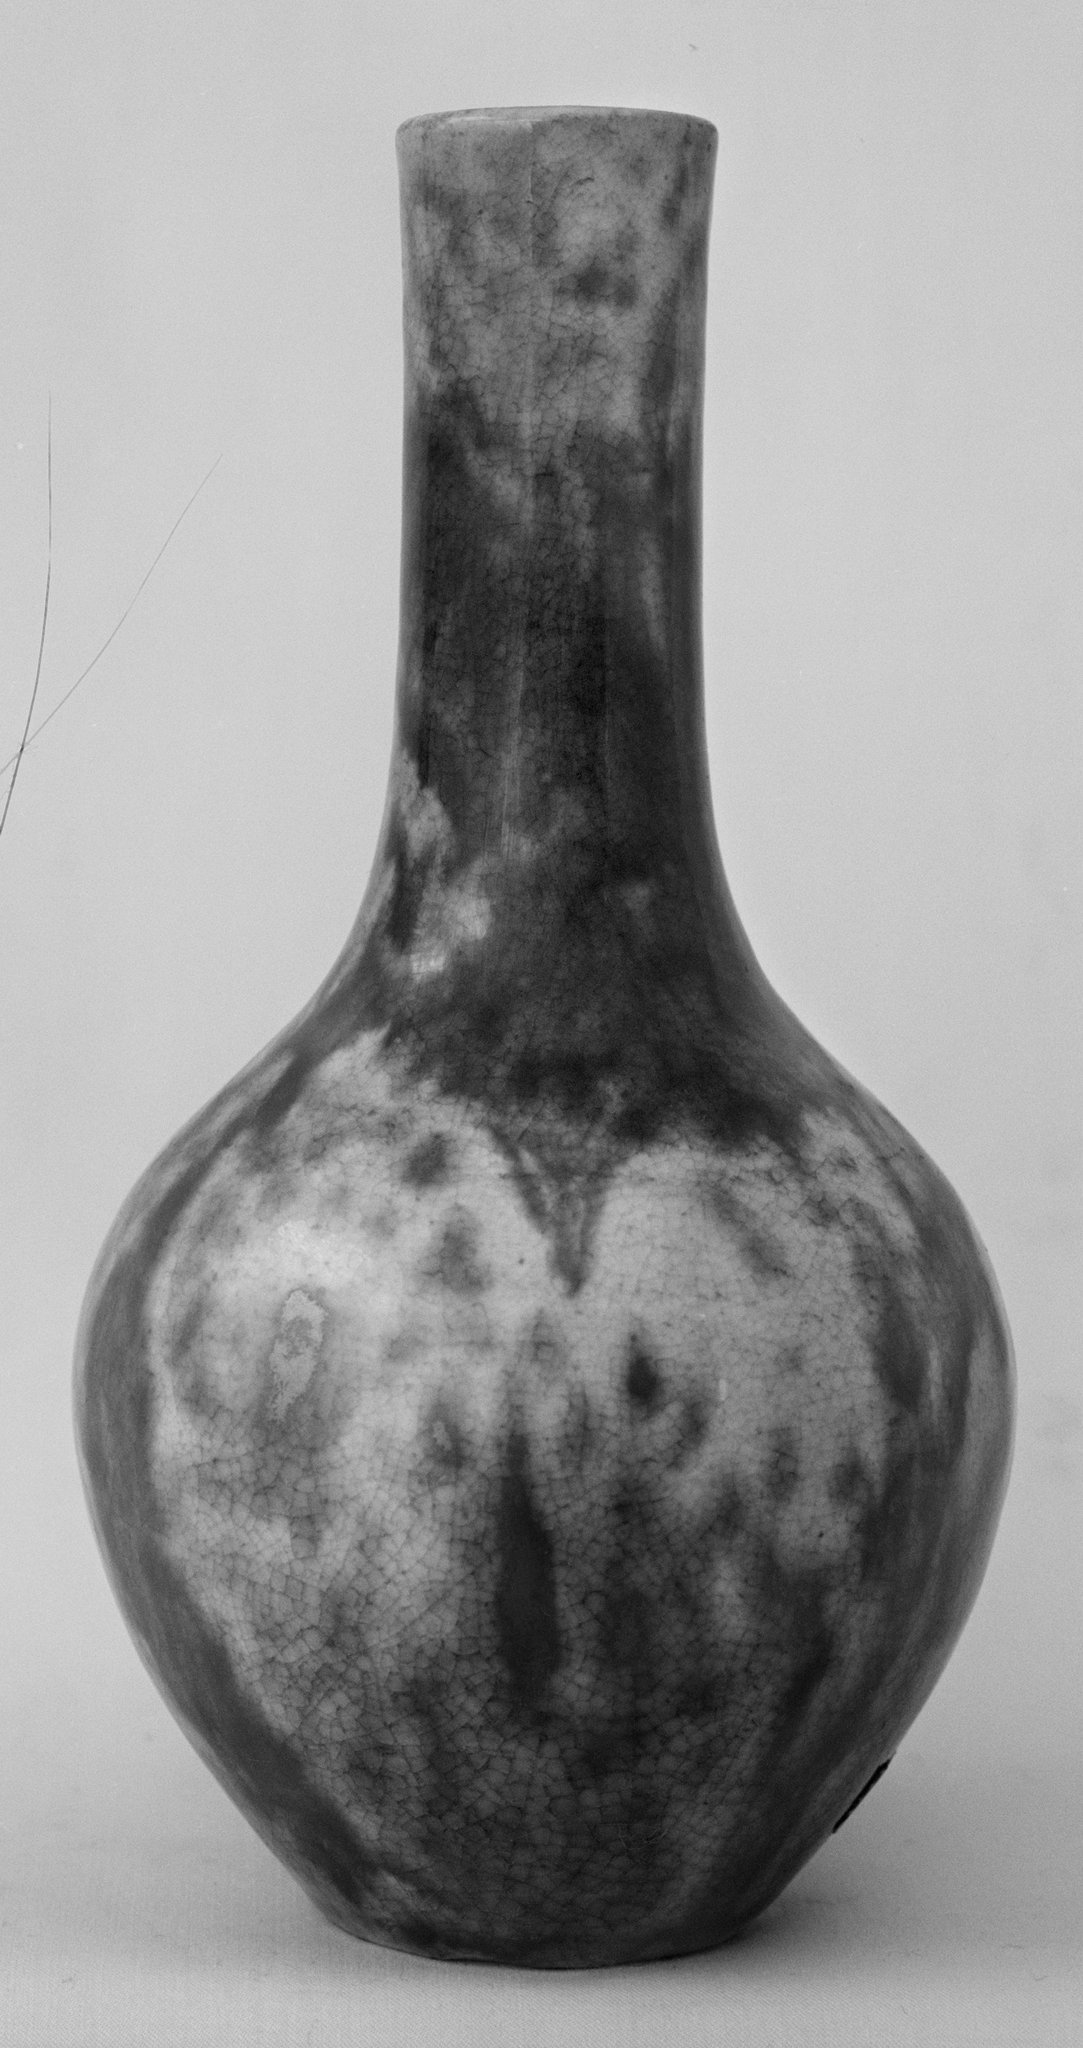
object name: bowl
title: Bowl with rock-imitating pattern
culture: chinese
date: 1767-1800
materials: enamel, porcelain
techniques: overglaze, painting, polychrome